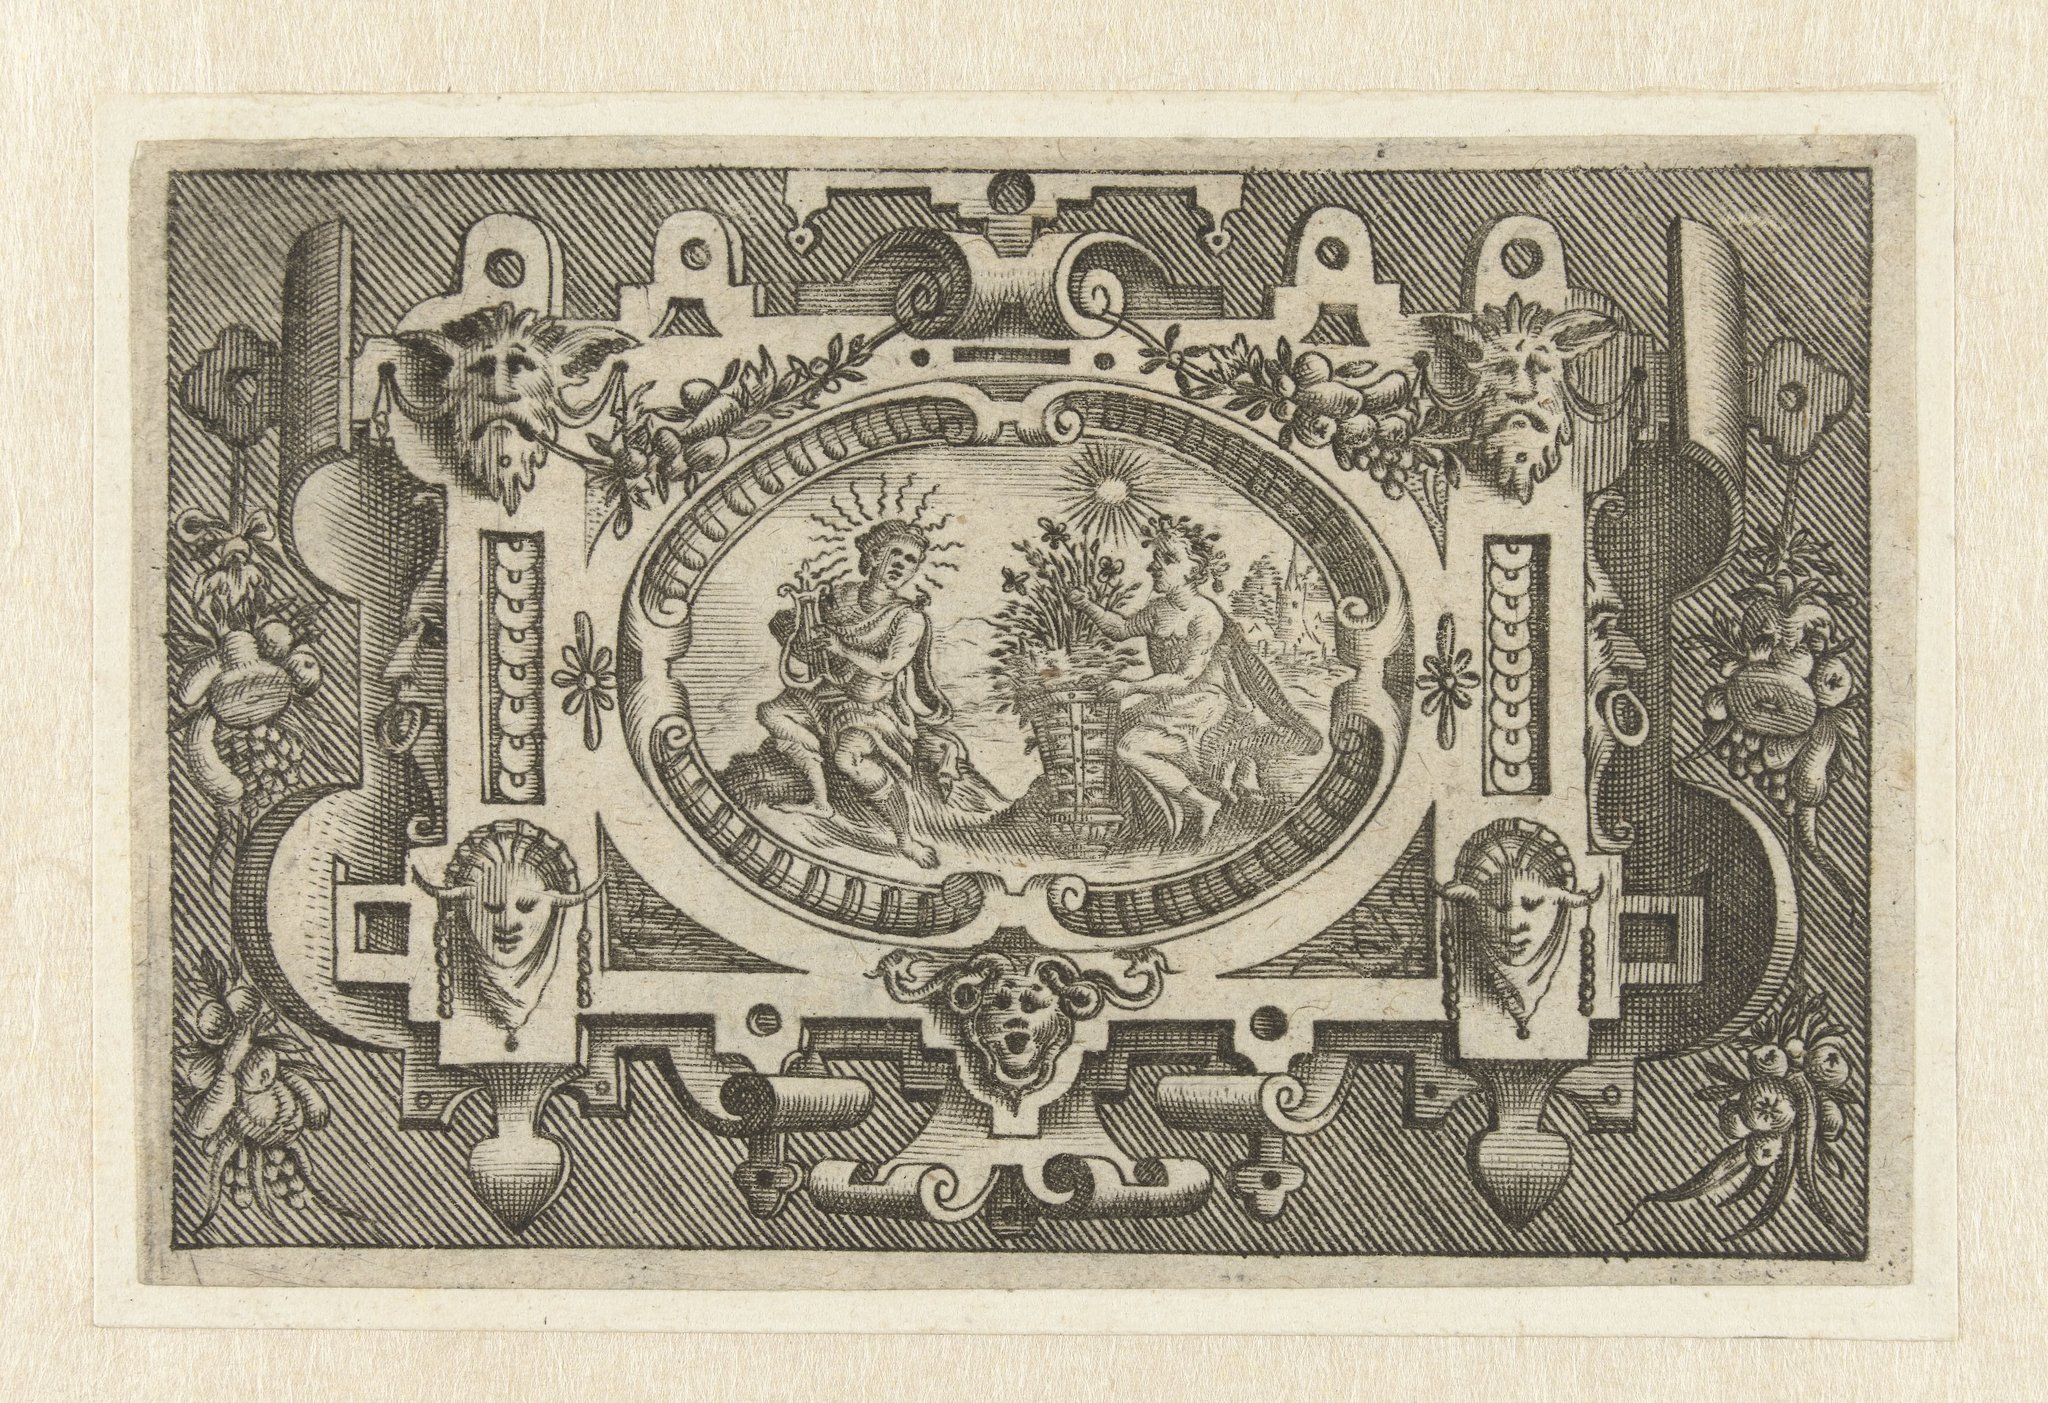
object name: ornament print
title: Lente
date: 1566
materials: paper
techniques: engraving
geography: netherlands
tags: (story of) apollo (phoebus), spring, 'ver'; 'primavera' (ripa)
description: Voorstellingen van de vier jaargetijden: de lente (Apollo). Blad uit serie bestaande uit een titelblad en 15 van de 16 bladen met cartouches met bijbelse en mythologische voorstellingen in een omlijsting van rolwerk en grotesken.